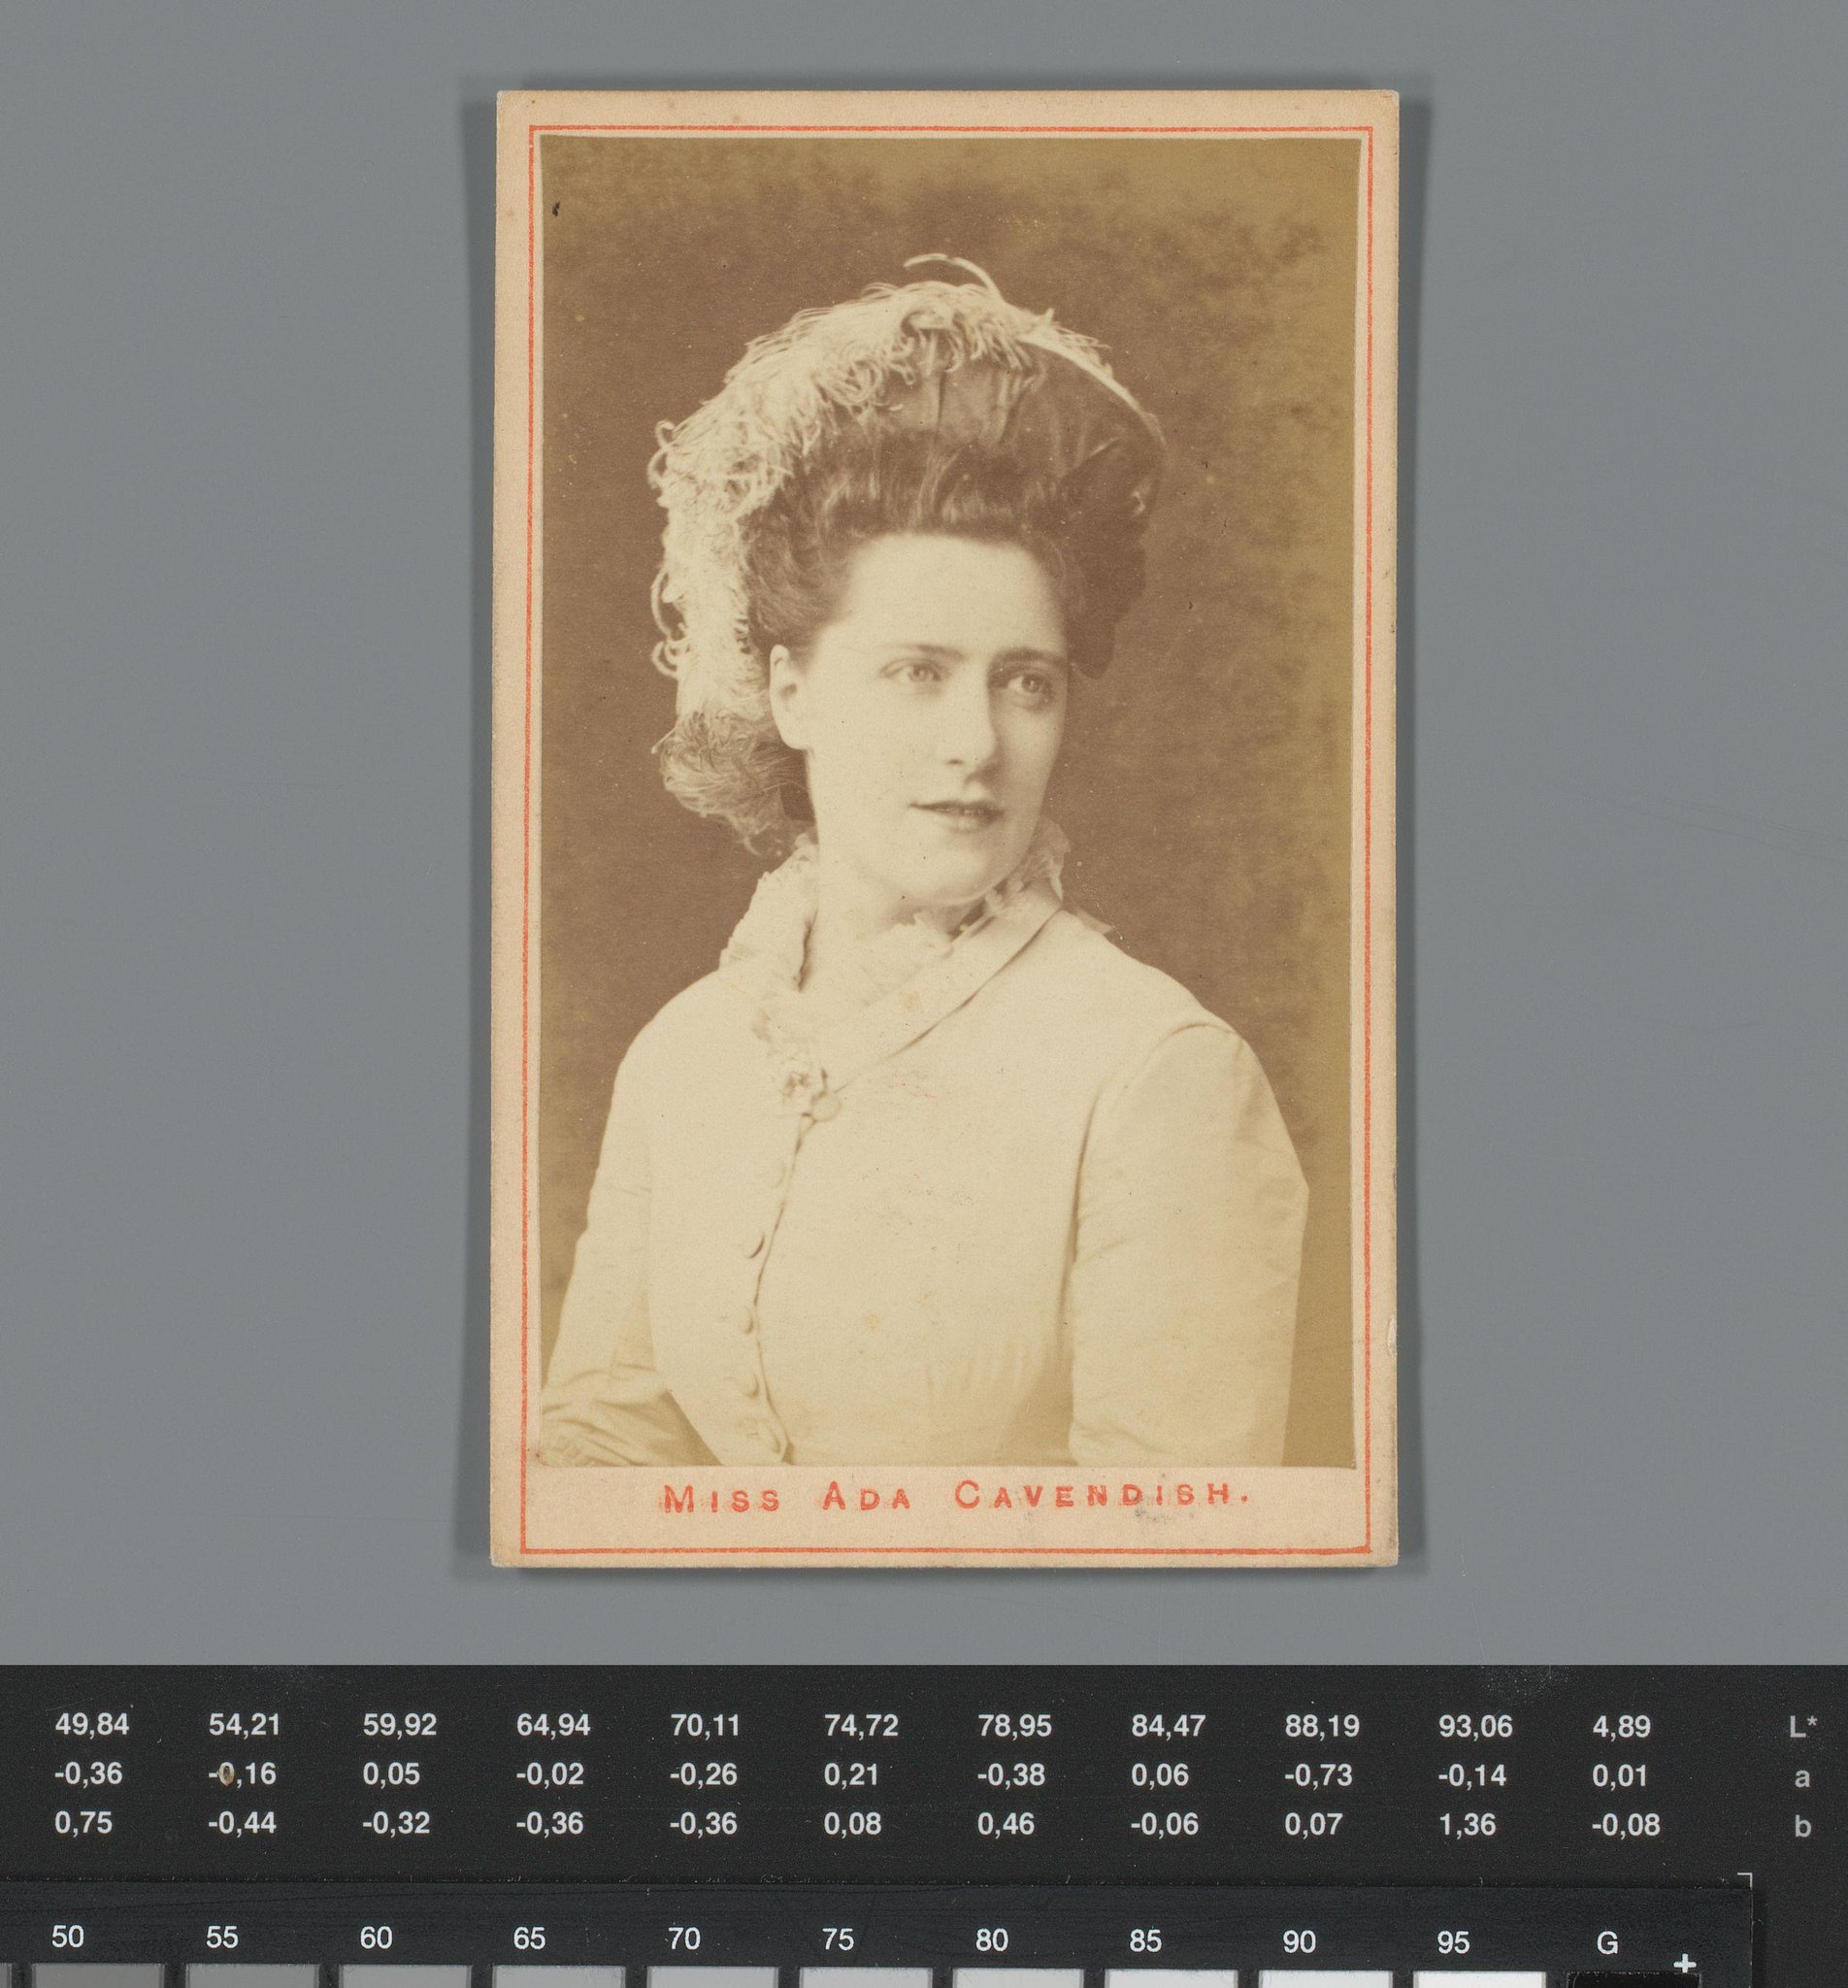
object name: photograph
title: Reclame voor een toneelstuk met portret van Ada Cavendish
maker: Anonymous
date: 1876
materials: cardboard, photographic support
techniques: albumen print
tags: advertising, historical persons - bb - woman, portrait of actor, actress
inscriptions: inscription: ‘(...)’